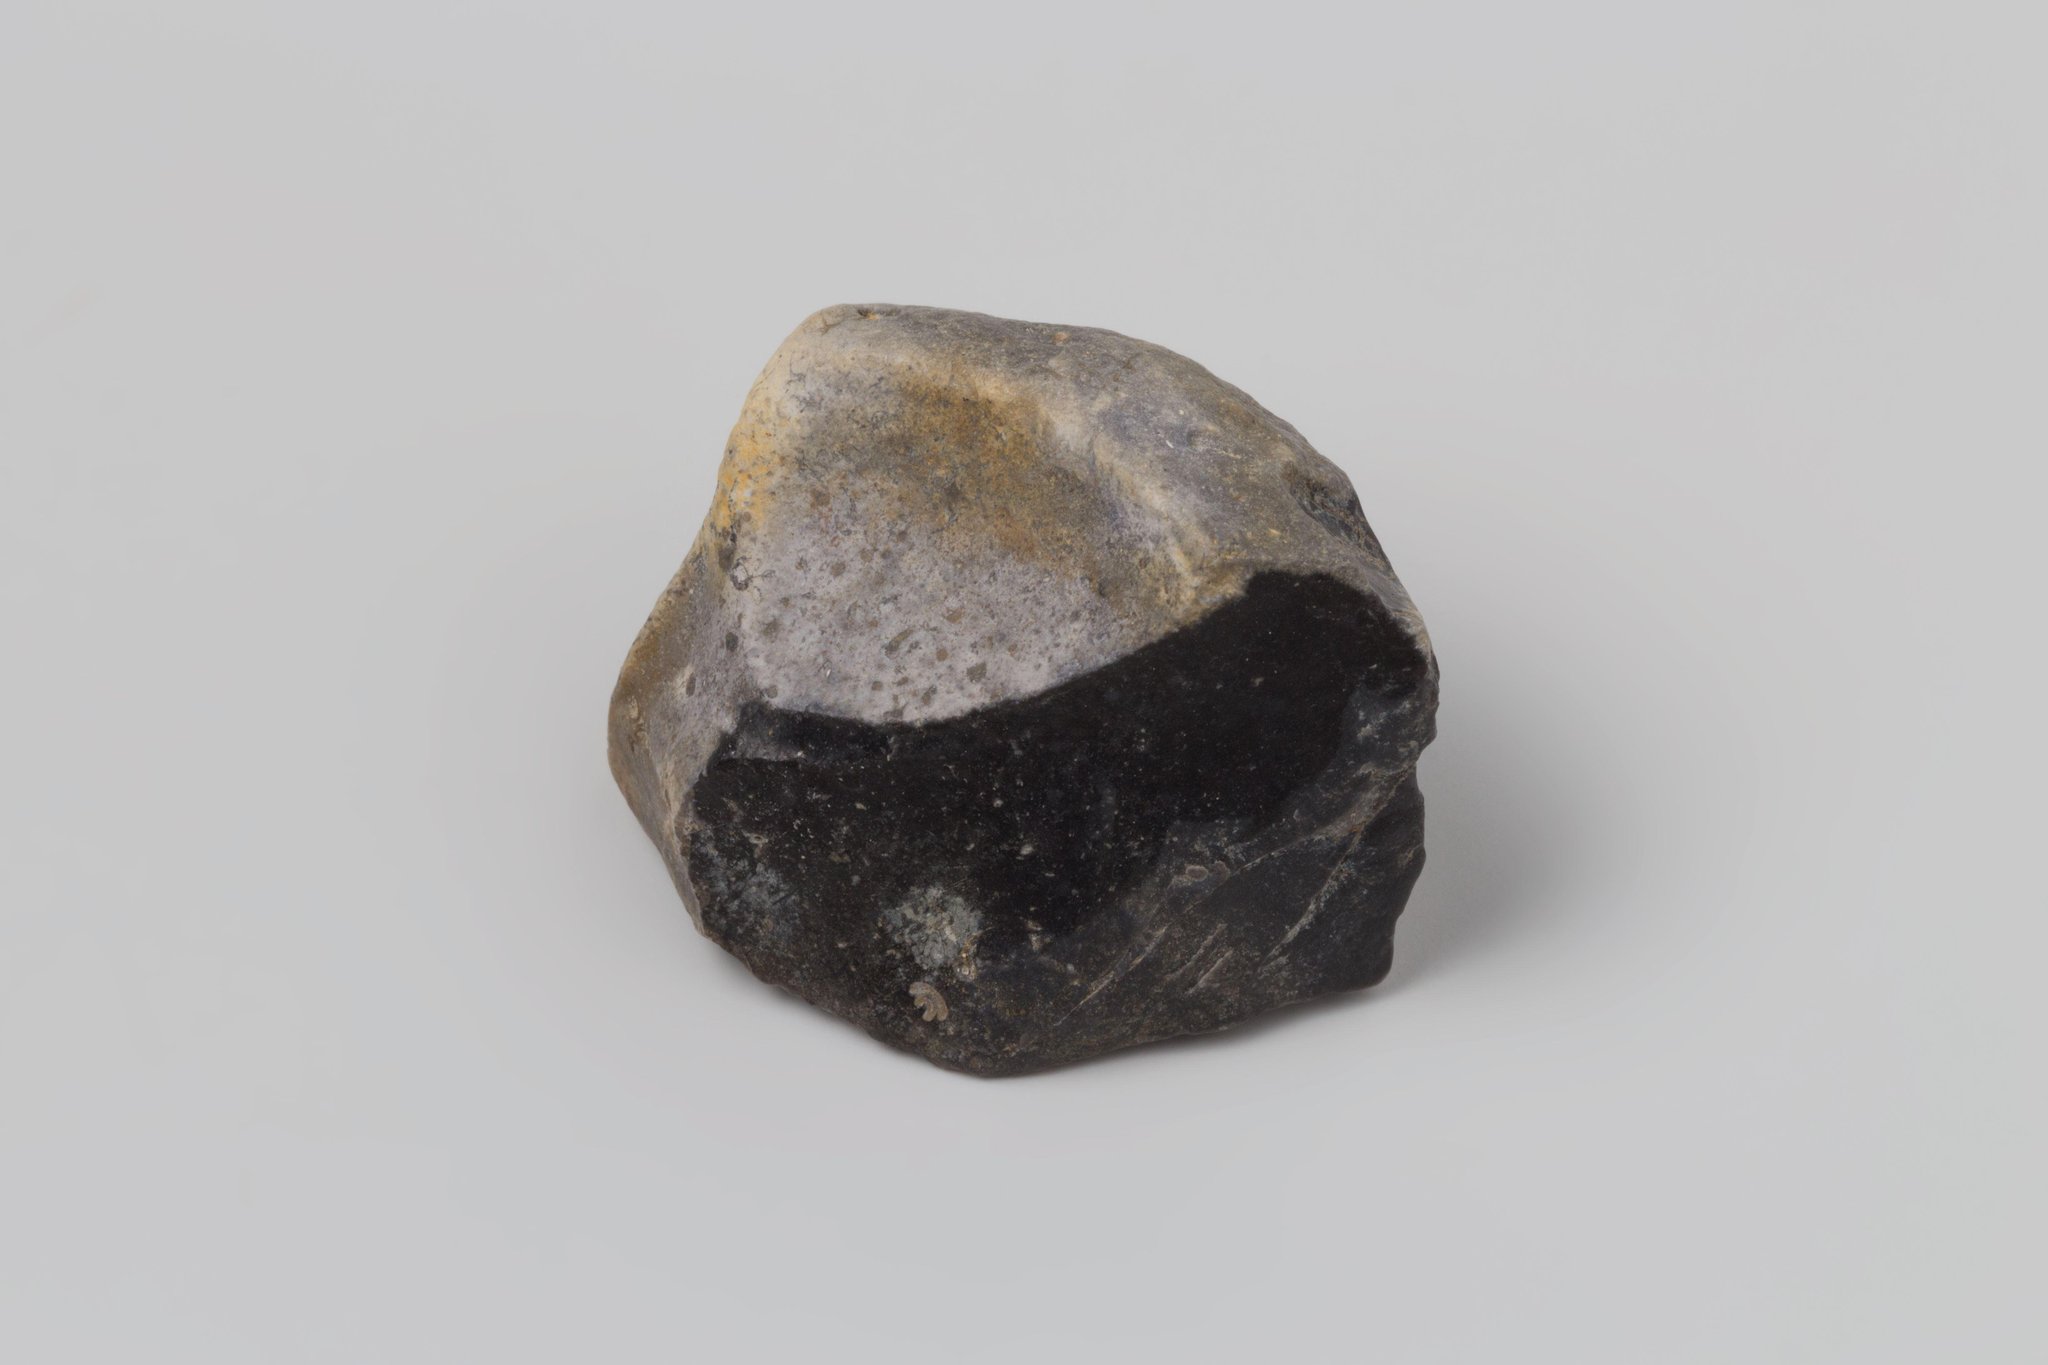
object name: flint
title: Vuursteen uit het wrak van de Oost-Indiëvaarder 't Vliegend Hart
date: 1730-1735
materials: stone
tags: 't vliegend hart (schip), verenigde oostindische compagnie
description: Vuursteen, van buiten wittig, waar de steen is gespleten glanzend zwart. Flint.